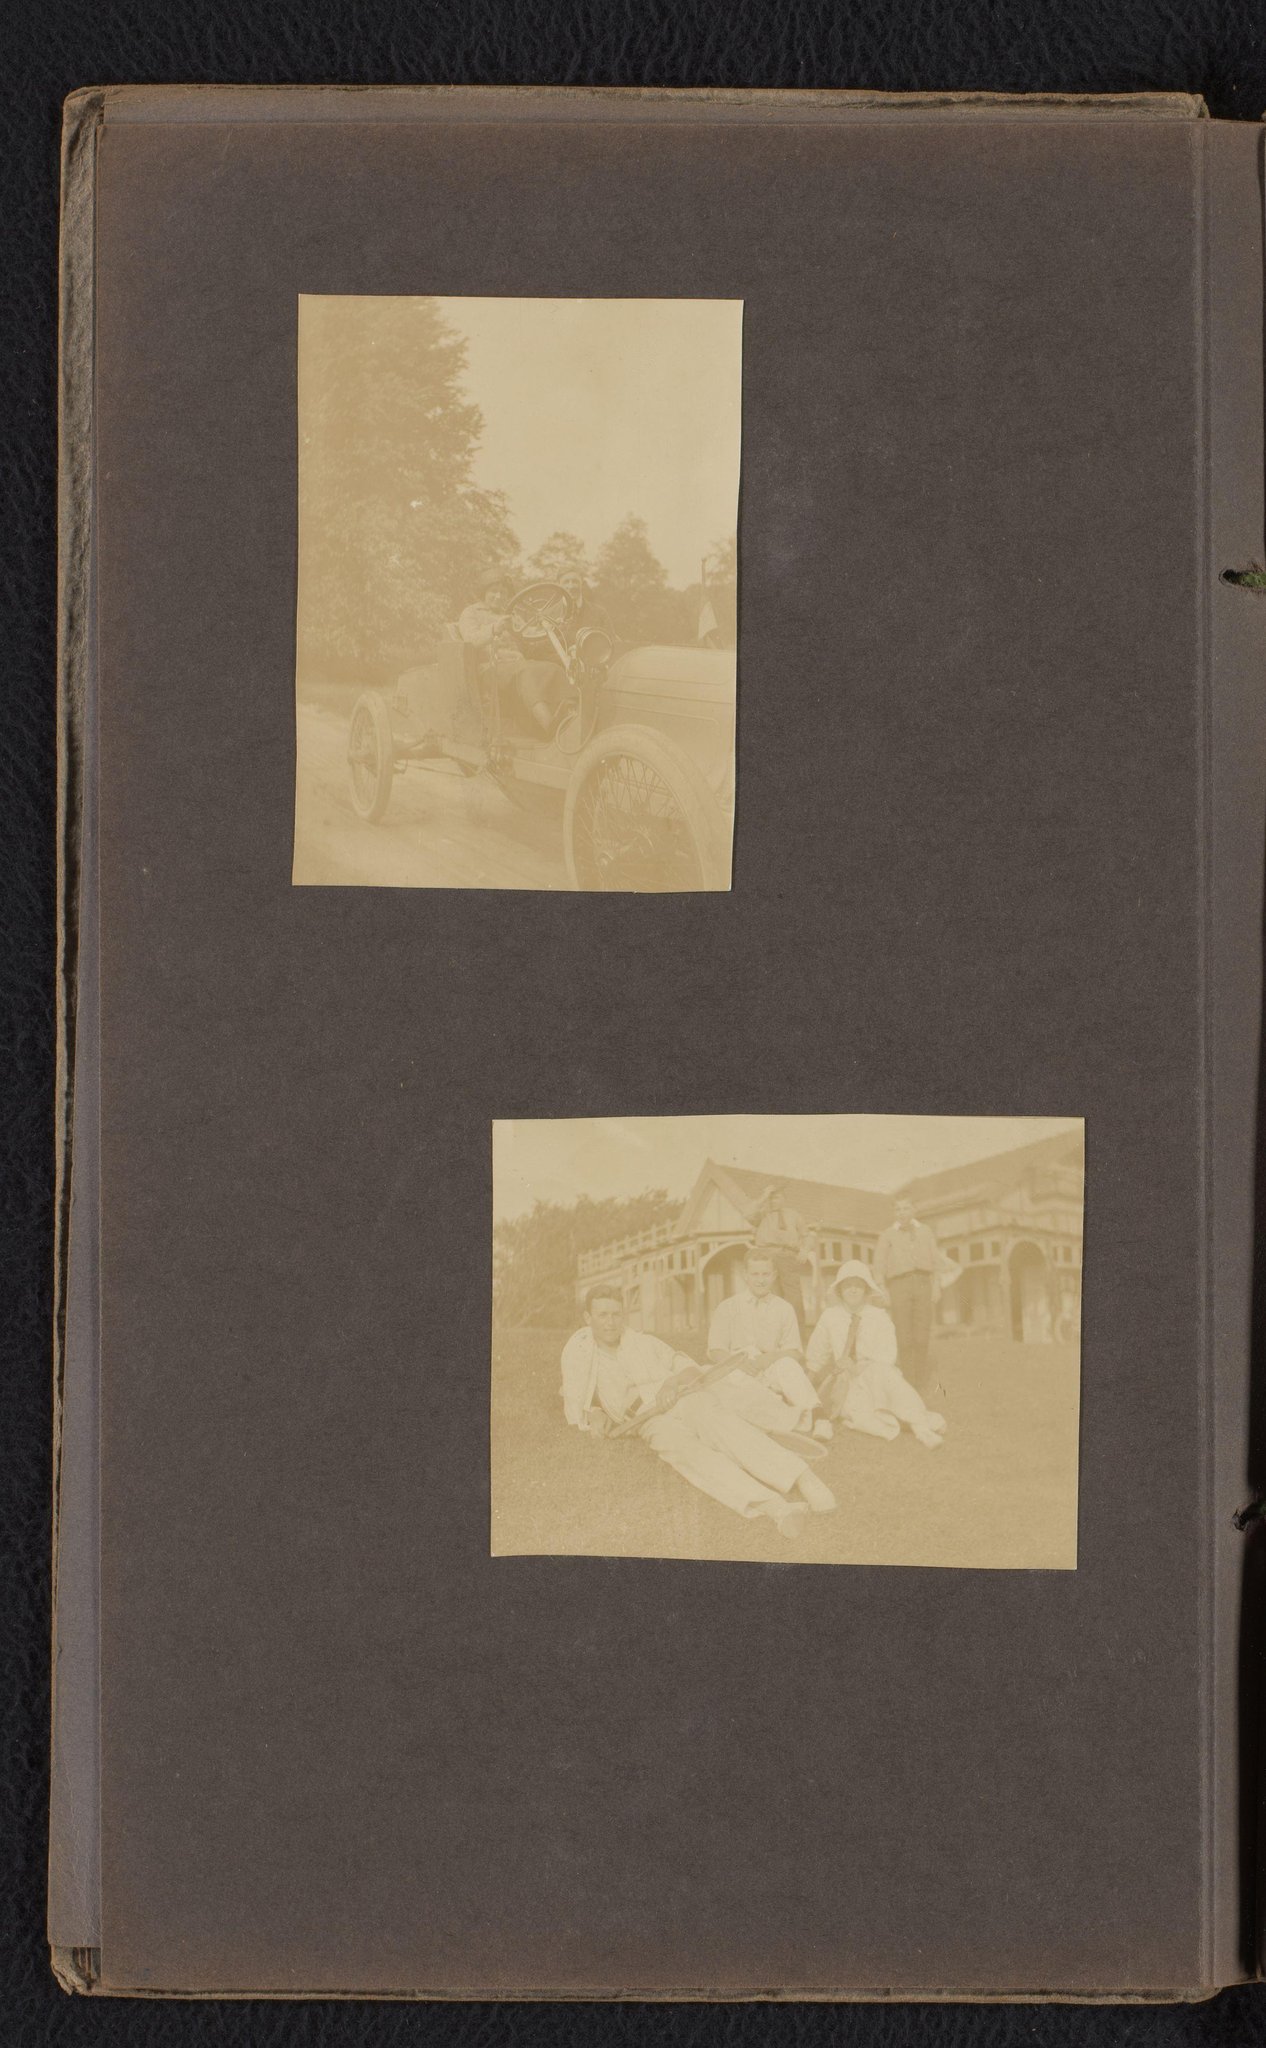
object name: album leaf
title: Vrienden van Loentje Onnen, waaronder Frans Paut en Alphie van Eeghen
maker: carolina frederika onnen (lien/loen)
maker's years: 1896-1983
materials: paper, cardboard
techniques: gelatin silver print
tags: anonymous historical persons portrayed in a group, in a group-portrait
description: Deze foto's zijn onderdeel van een album.